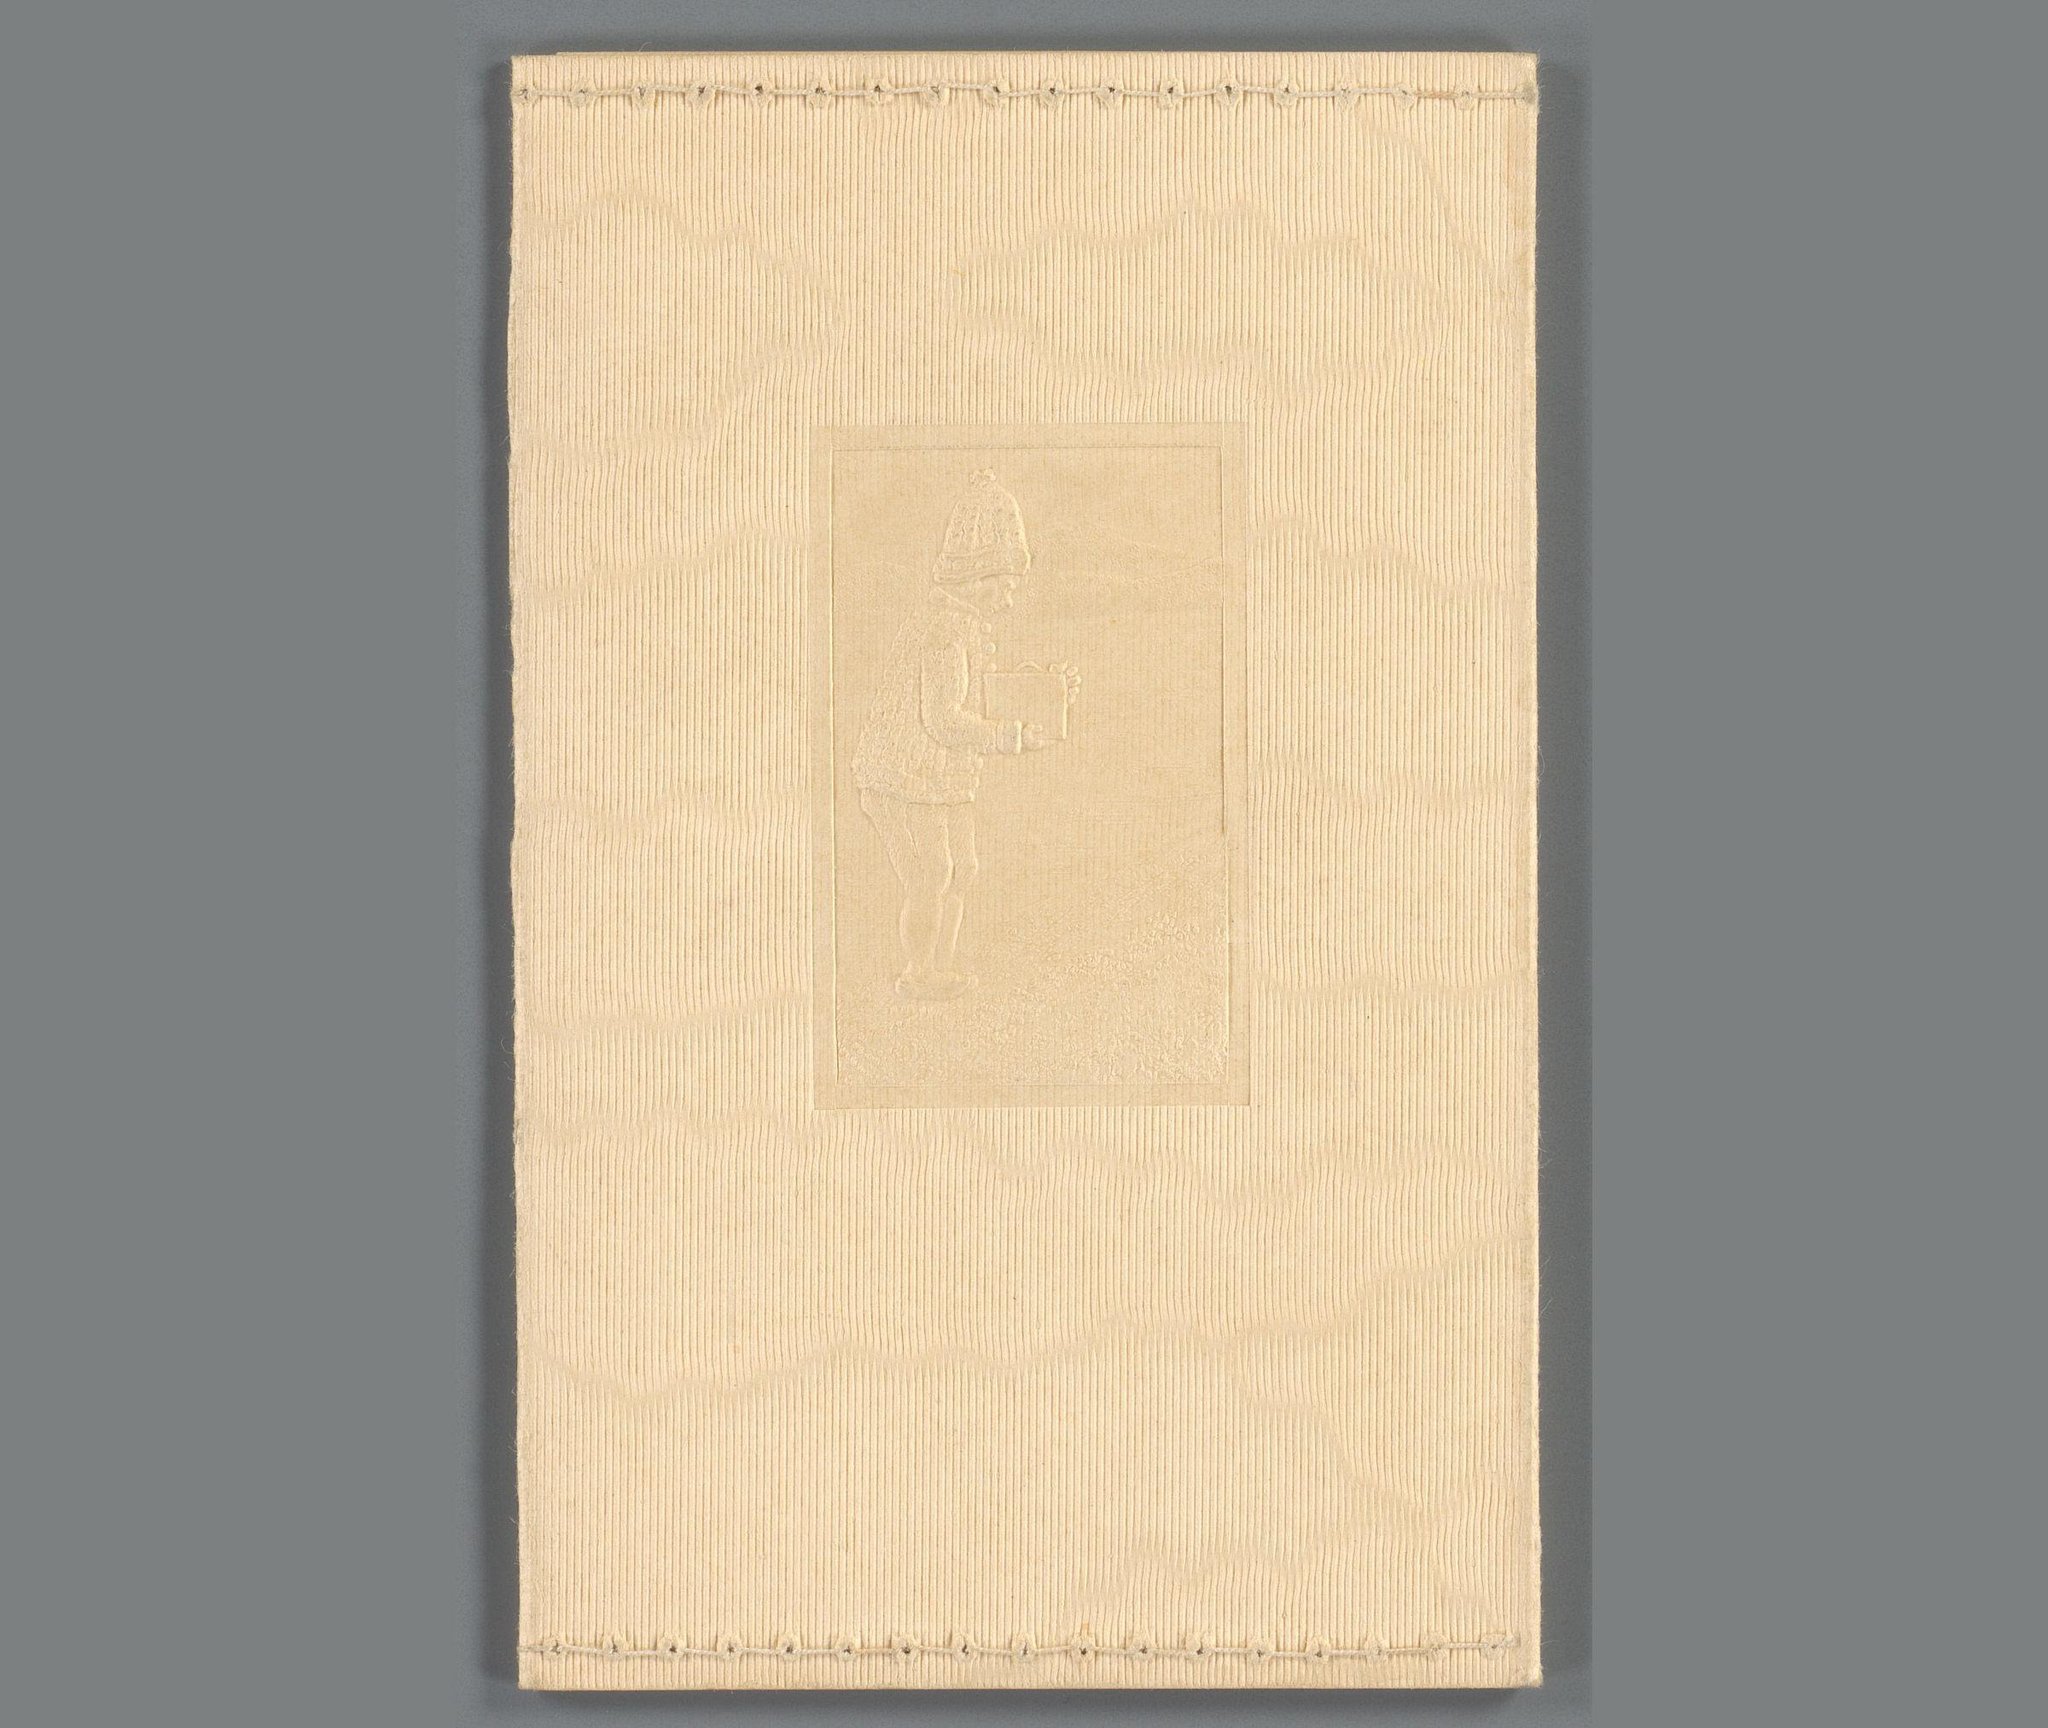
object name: wrapper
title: Omslag voor foto's, met voorstelling van een jongen met boxcamera in een sneeuwlandschap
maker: Anonymous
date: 1900-1940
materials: cardboard, textile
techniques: blind stamped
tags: boy (child between toddler and youth), taking photographs - cc - out of doors